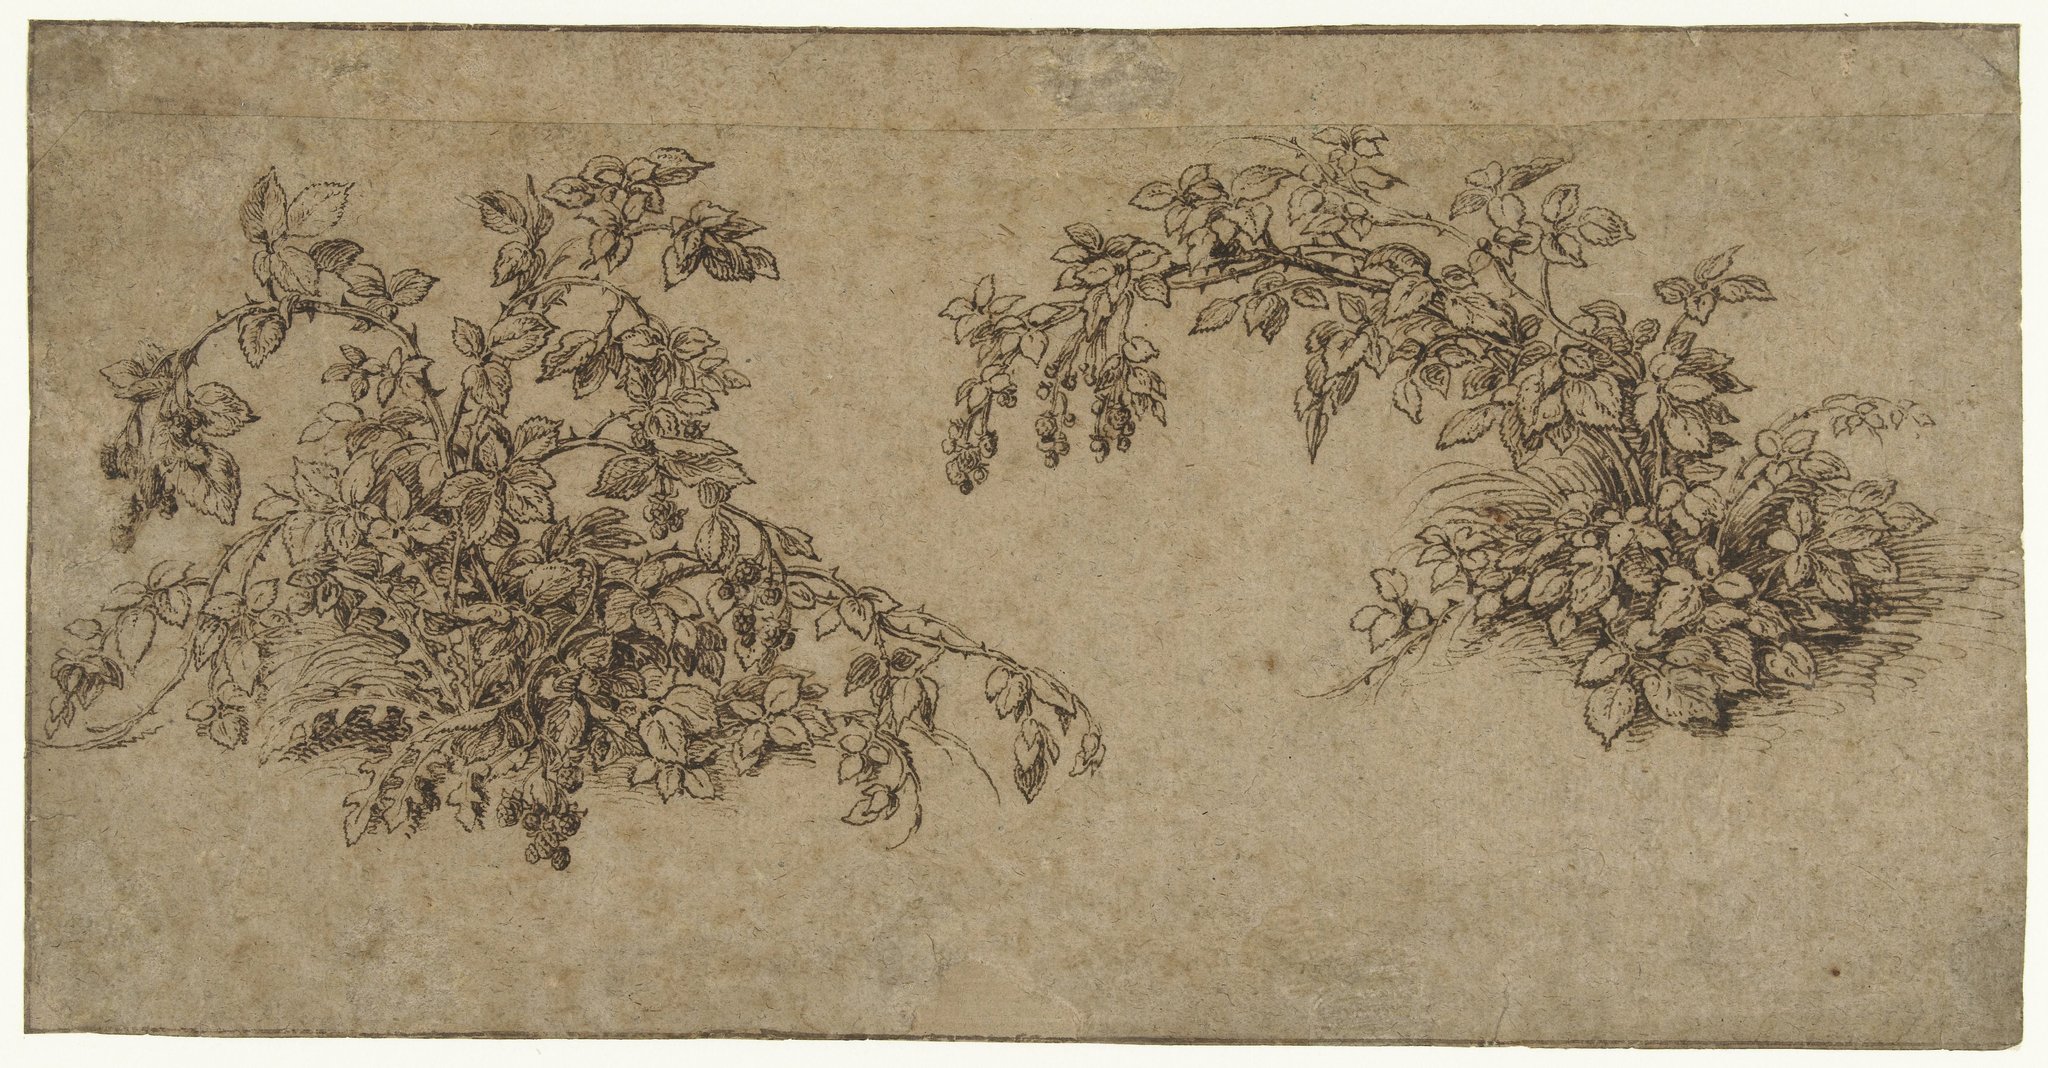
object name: drawing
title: Twee braamstruiken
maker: jacques de gheyn (ii)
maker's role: painter, print maker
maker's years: 1565-1629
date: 1575-1625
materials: paper, ink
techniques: pen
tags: shrubs: blackberry-bush